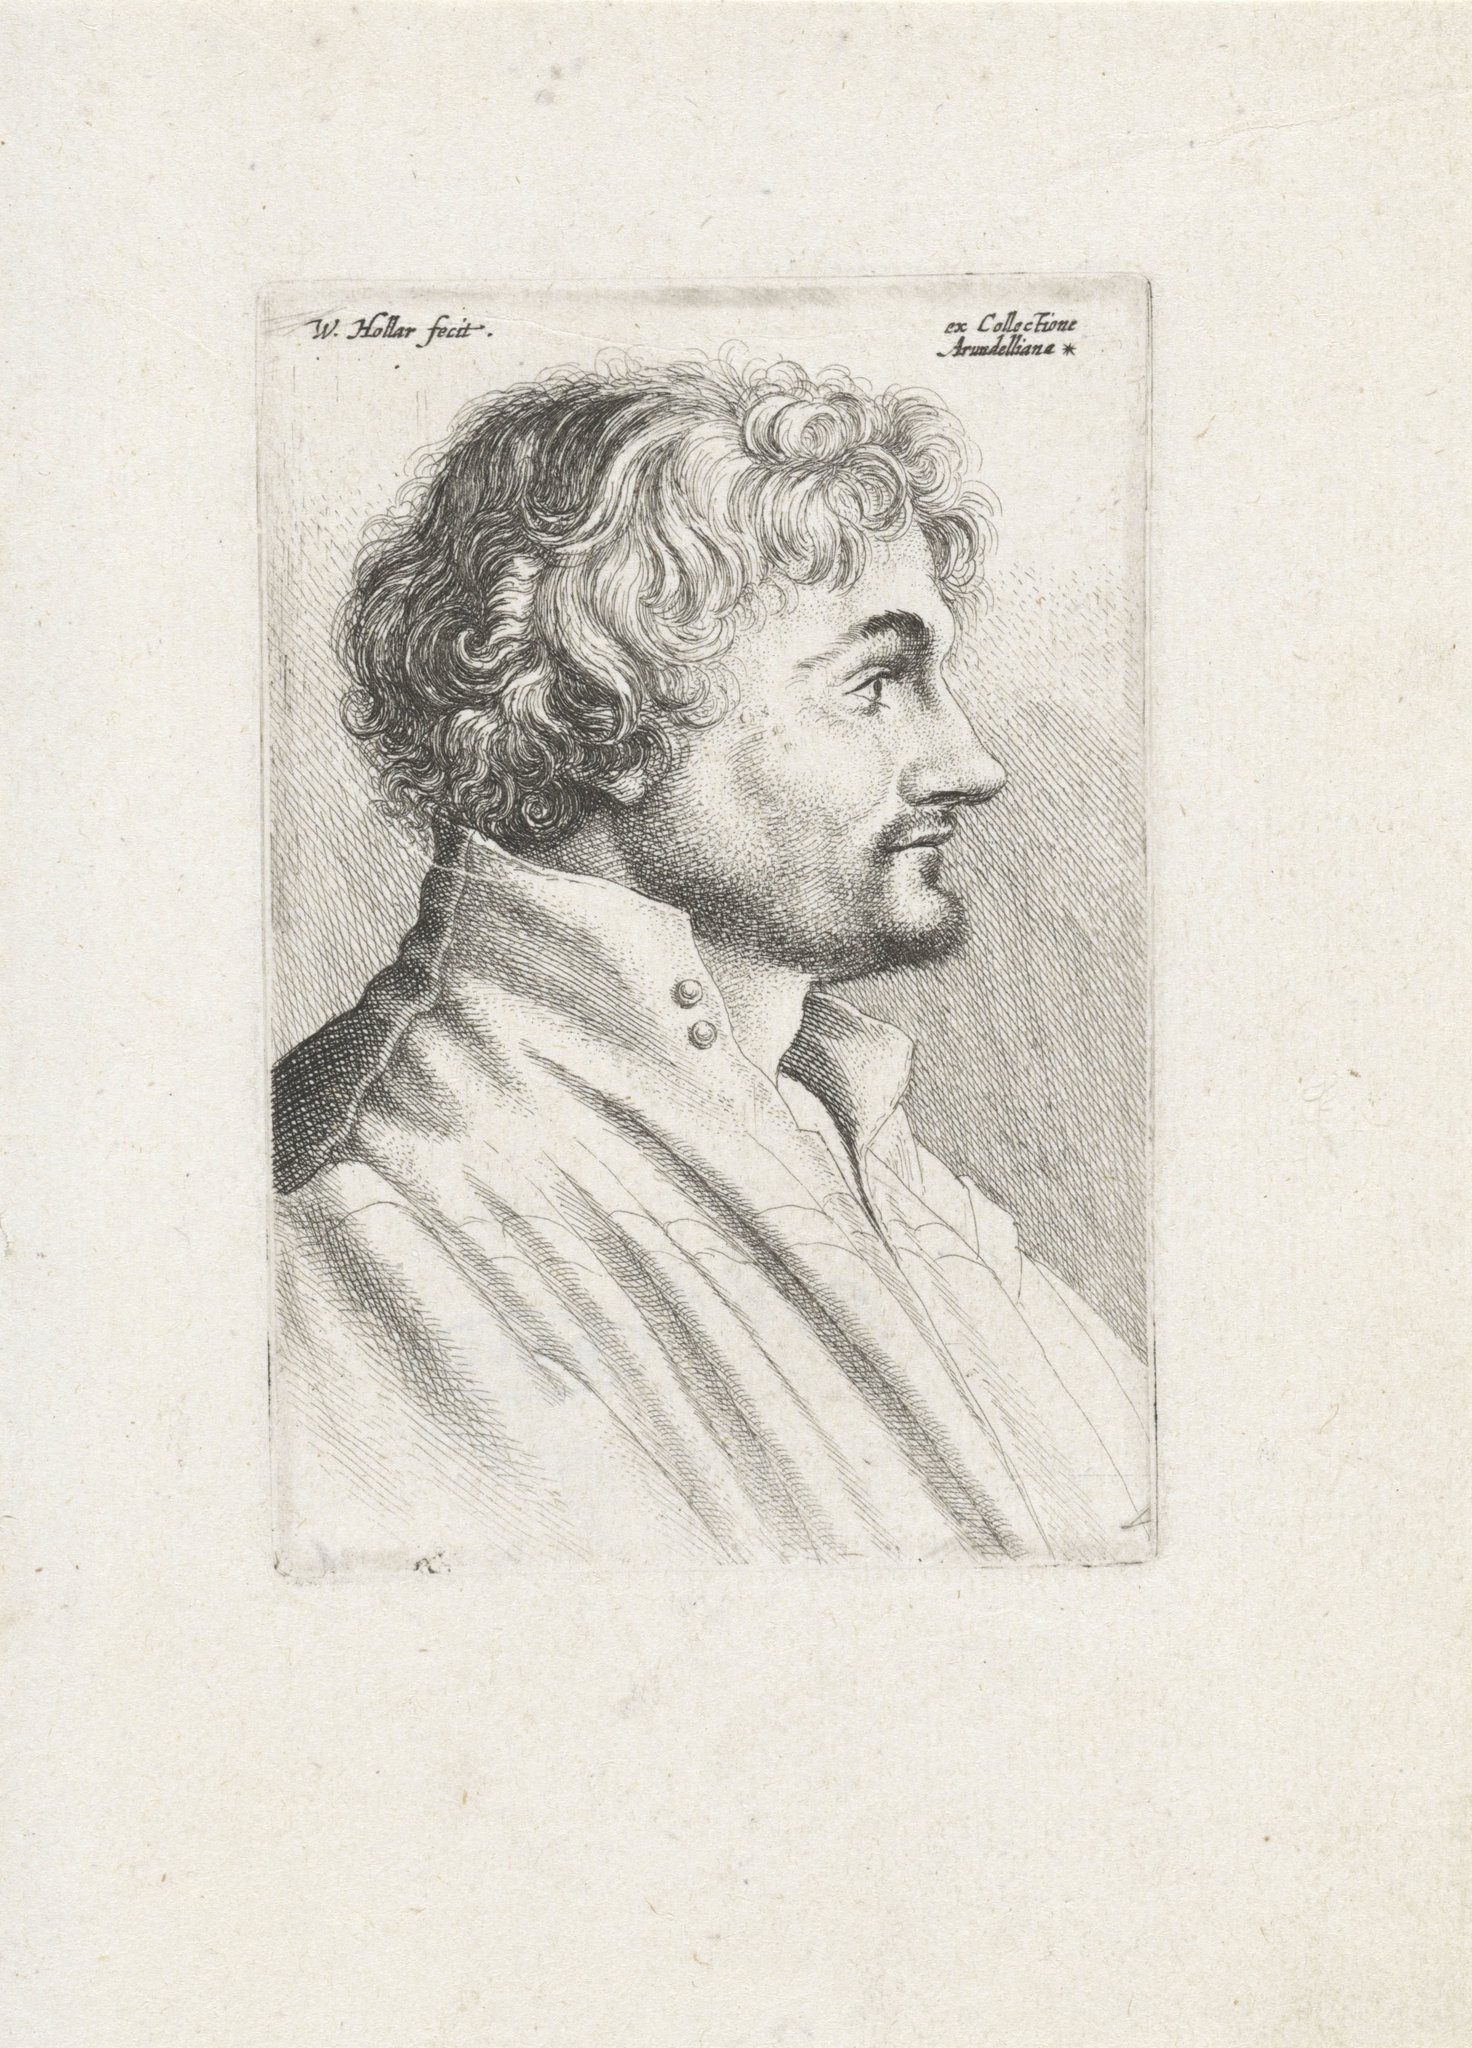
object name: print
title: Portret van een man met borstelige baard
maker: wenceslaus hollar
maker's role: draughtsman, print maker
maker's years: 1607-1677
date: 1644-1652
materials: paper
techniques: etching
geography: antwerp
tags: anonymous historical person portrayed alone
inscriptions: collector's mark: Lugt 2228